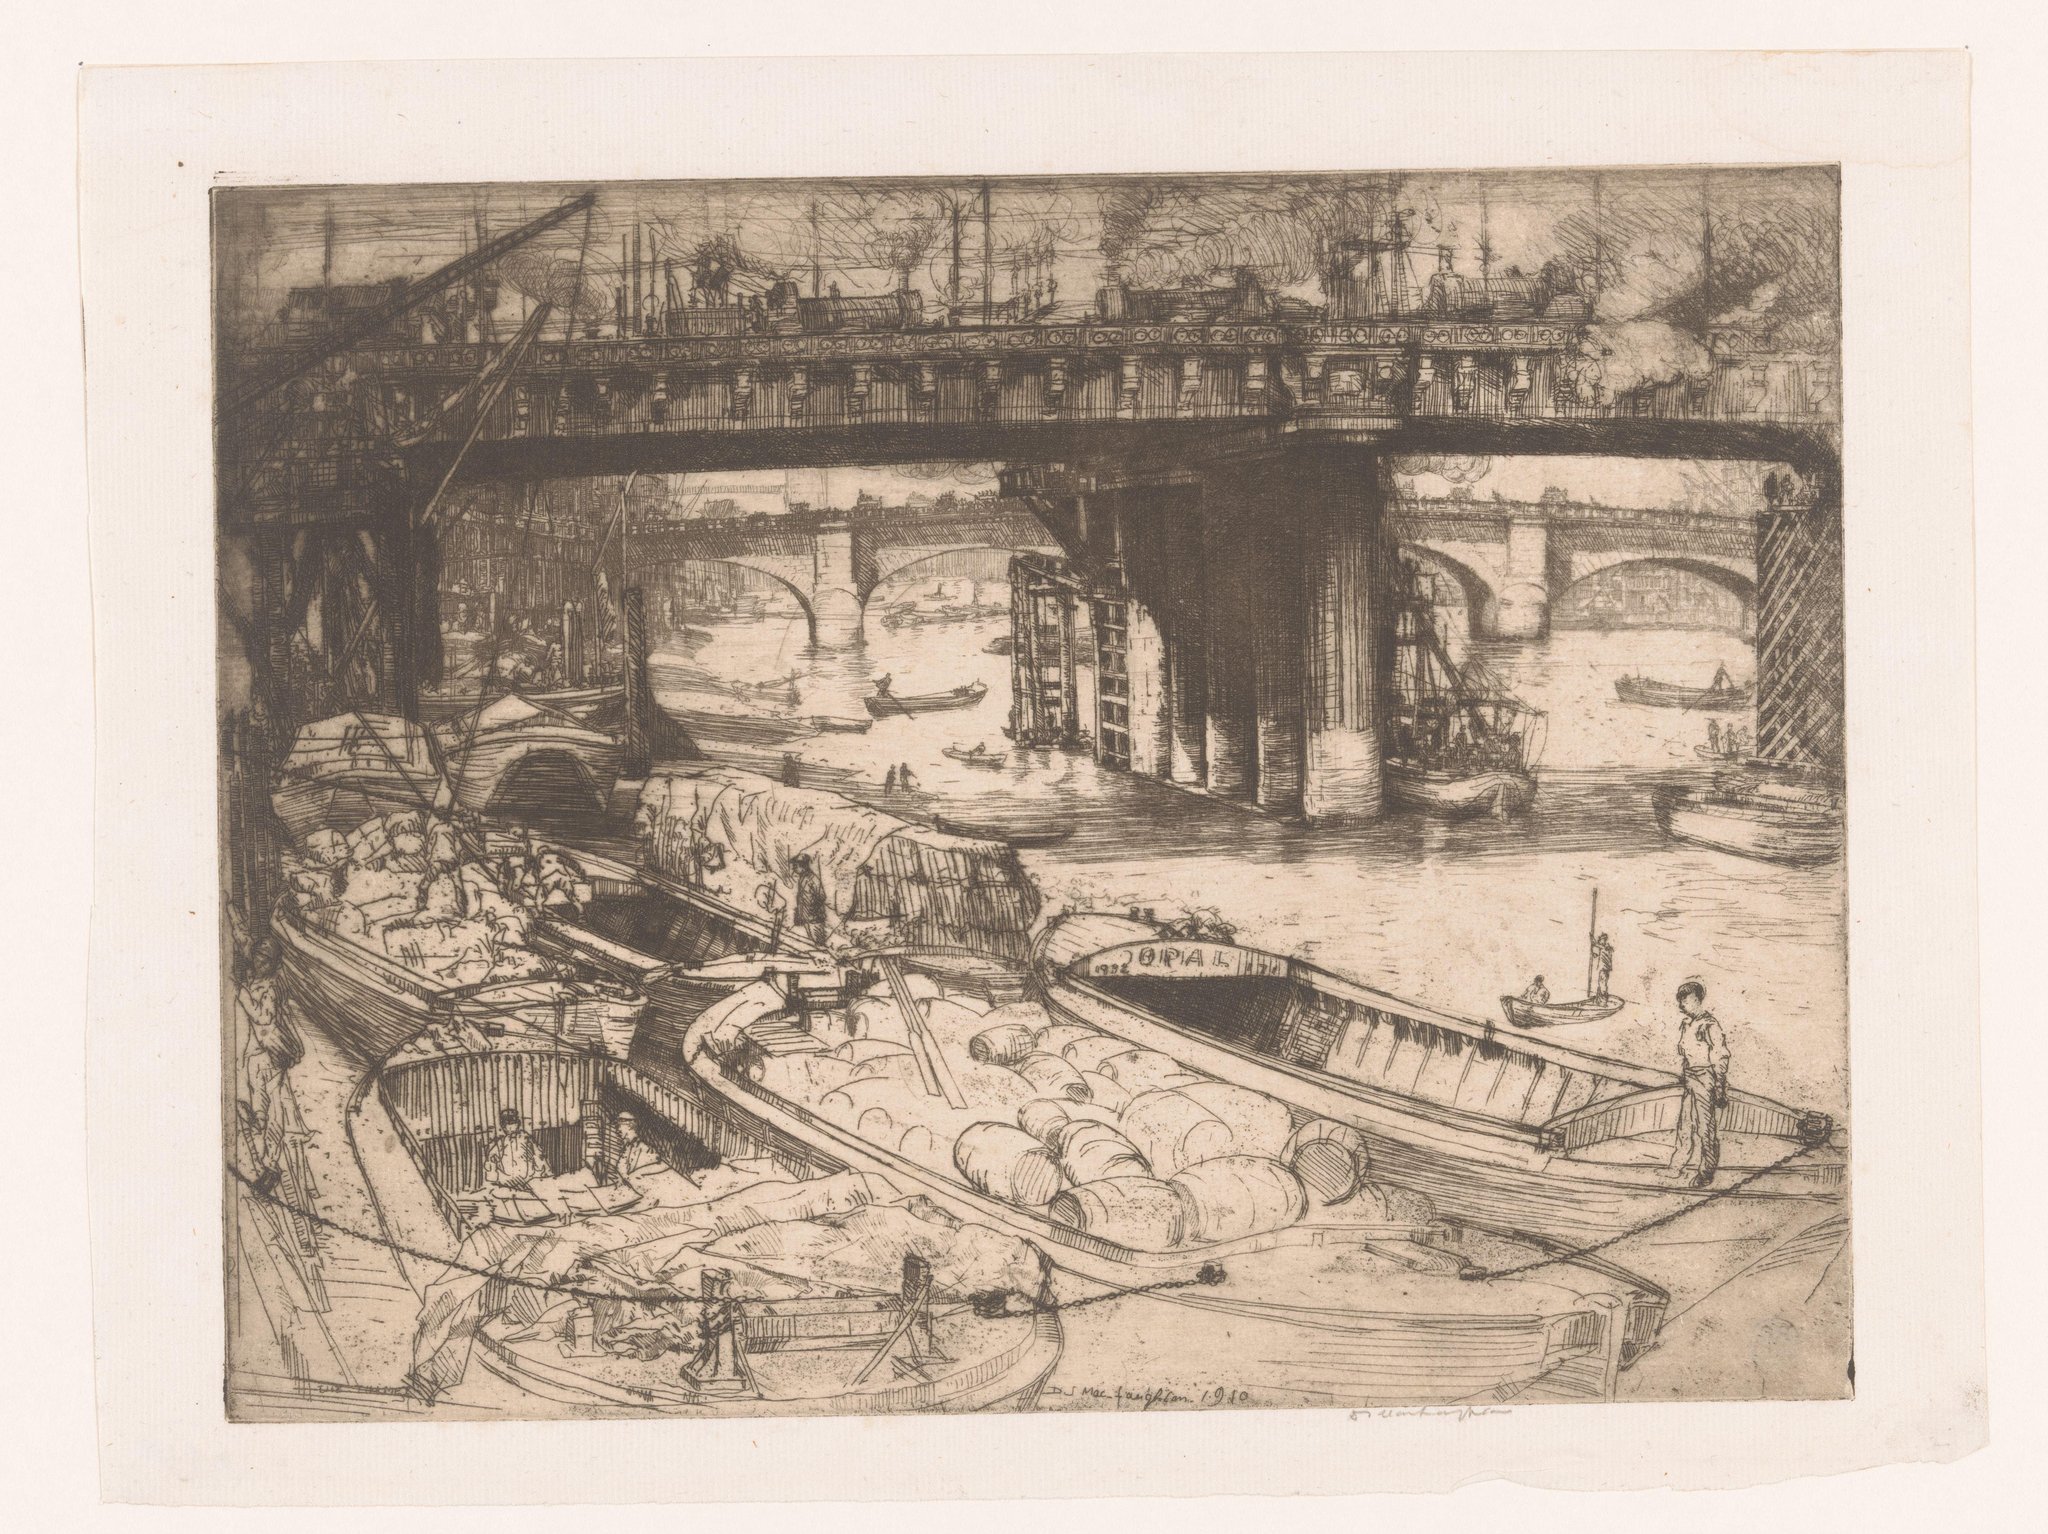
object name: print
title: Laag water in de Theems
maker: donald shaw maclaughlan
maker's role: painter, print maker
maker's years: 1876-1938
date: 1910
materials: paper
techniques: etching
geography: london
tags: city-view in general; 'veduta', freight vessel, pier, quay, wharf, railway, tramway; rack railway, bridge, quay, steam locomotive, thames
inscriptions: collector's mark: Lugt 2213a, collector's mark: Lugt 2760, collector's mark: Lugt 2228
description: Vrachtschuiten in de Theems in Londen bij laag water onder een spoorbrug Cannon Street Railway Bridge waaroverheen stoomtreinen rijden. In de verte Waterloo Bridge.